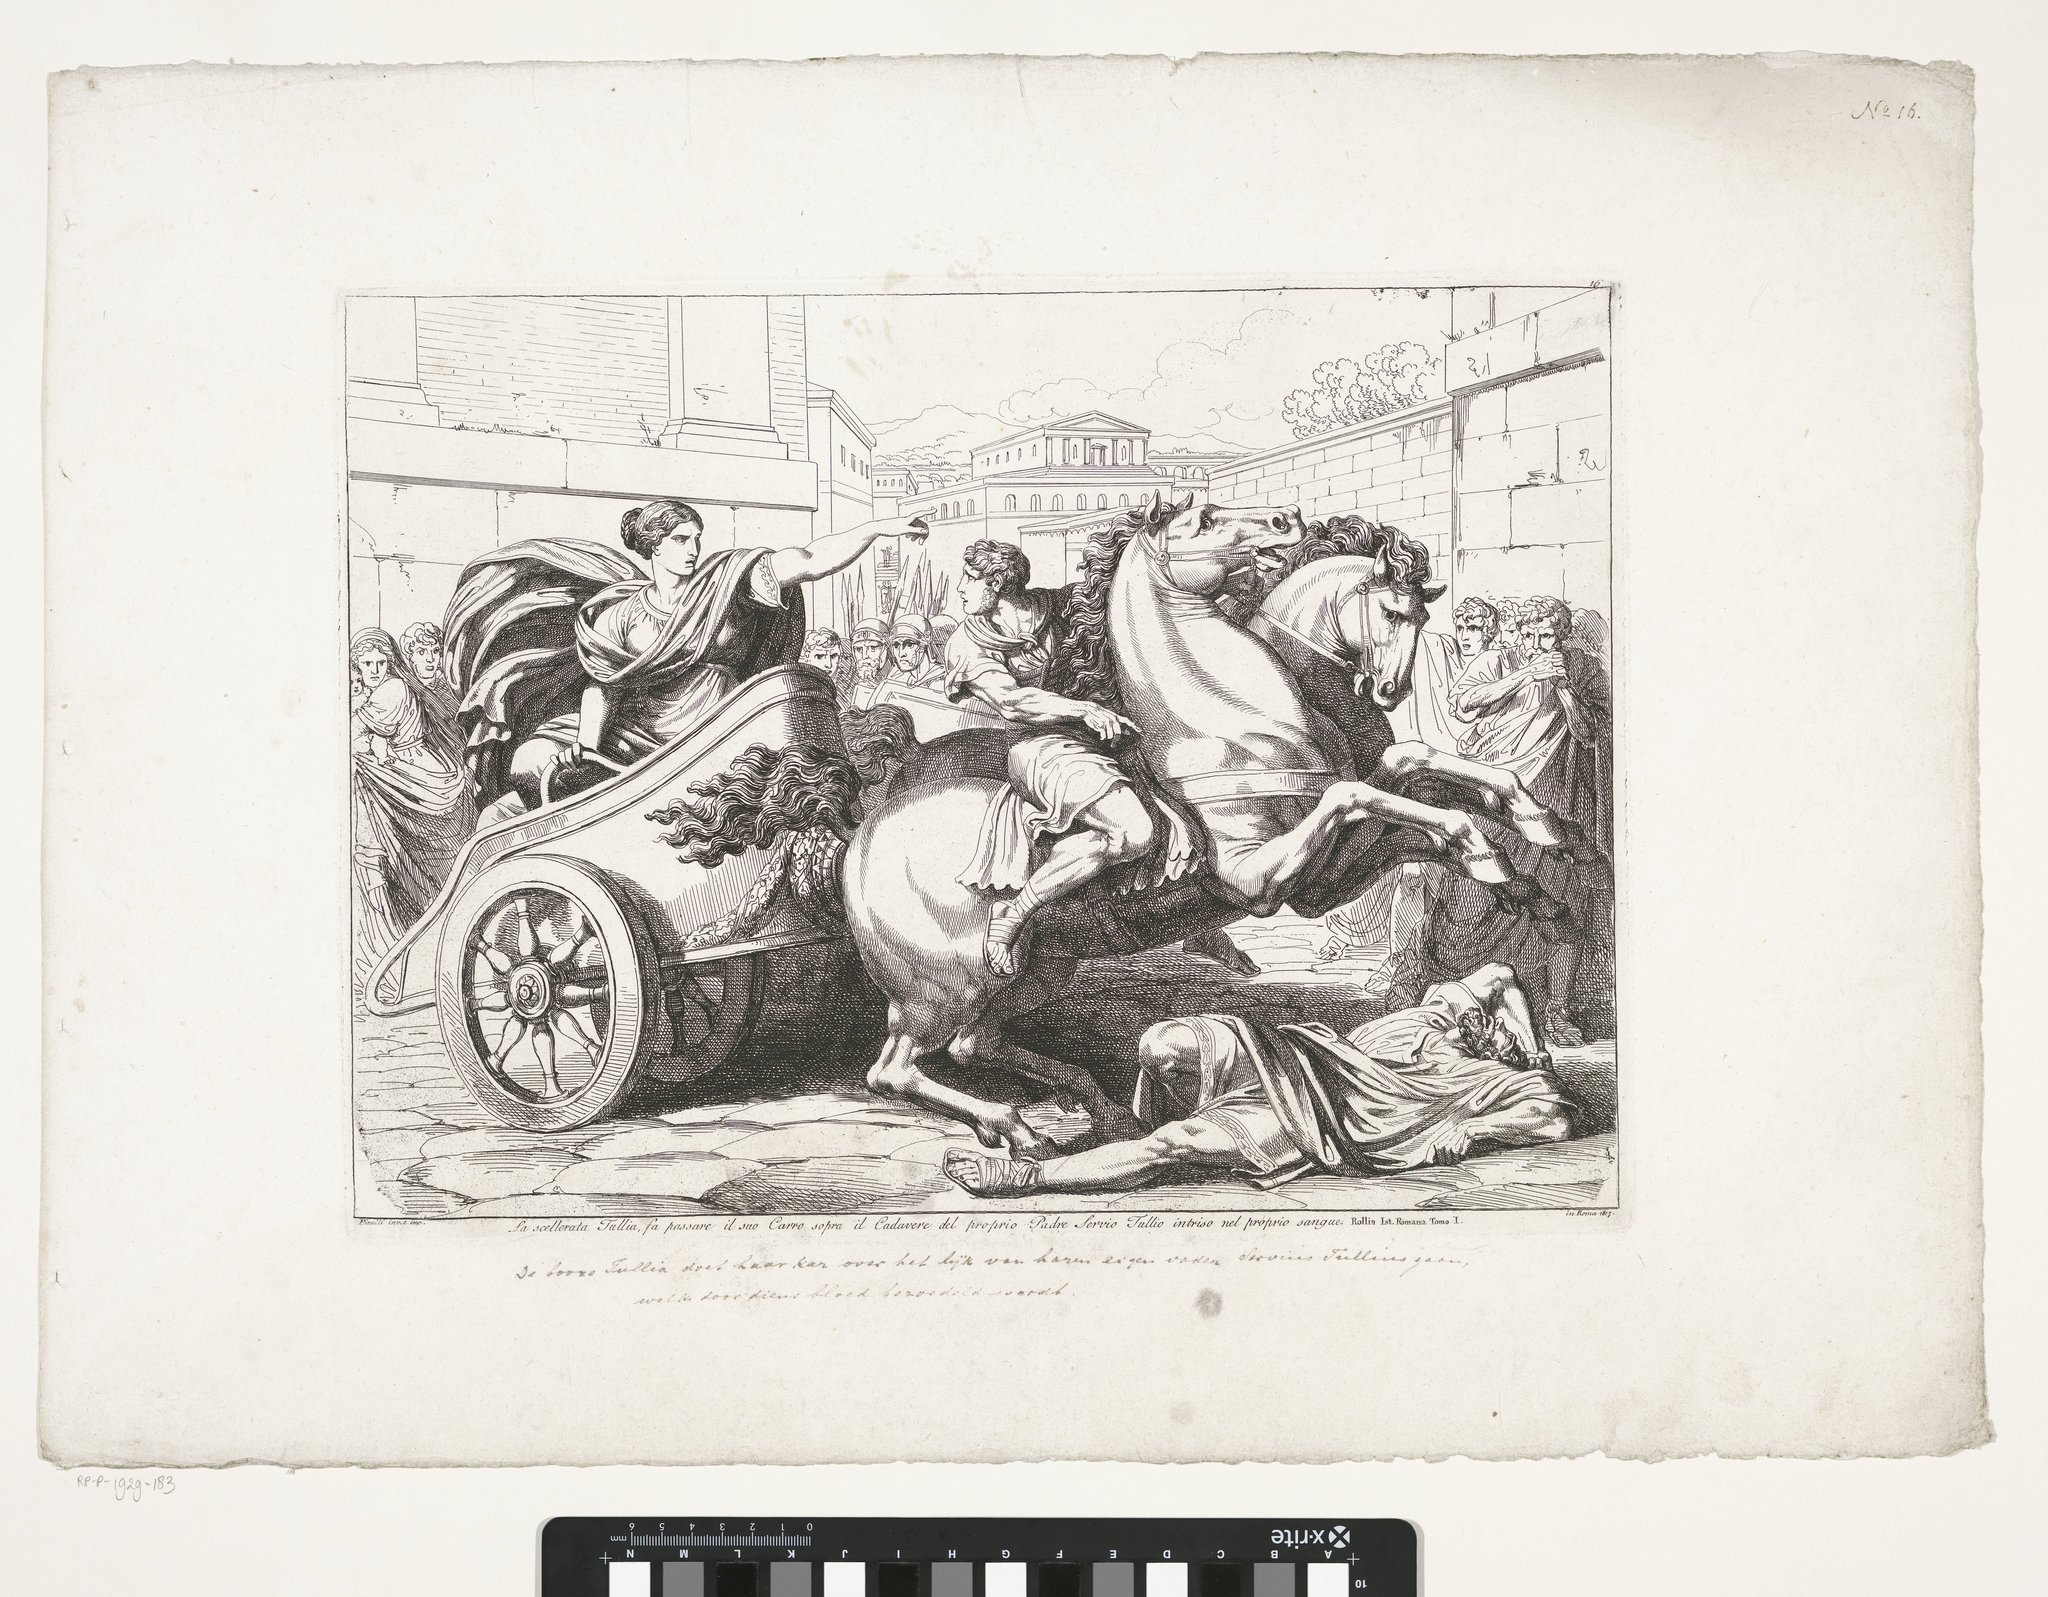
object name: print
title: Tullia rijdt over het lichaam van haar vader Tullius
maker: bartolomeo pinelli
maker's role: draughtsman, print maker, sculptor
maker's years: 1781-1835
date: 1817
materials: paper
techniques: etching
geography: rome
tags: tullia drives her chariot over the dead body of her father servius tullius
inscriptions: collector's mark: Lugt 2228, inscription: ‘De booze Tullia doet haar kar over het lijk van haren eigen vader Servius Tullius gaan, / welk door diens bloed bezoedeld wordt.’, number: ‘No 16.’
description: Deze prent maakt deel uit van een reeks van 101 prenten over de geschiedenis van Rome.